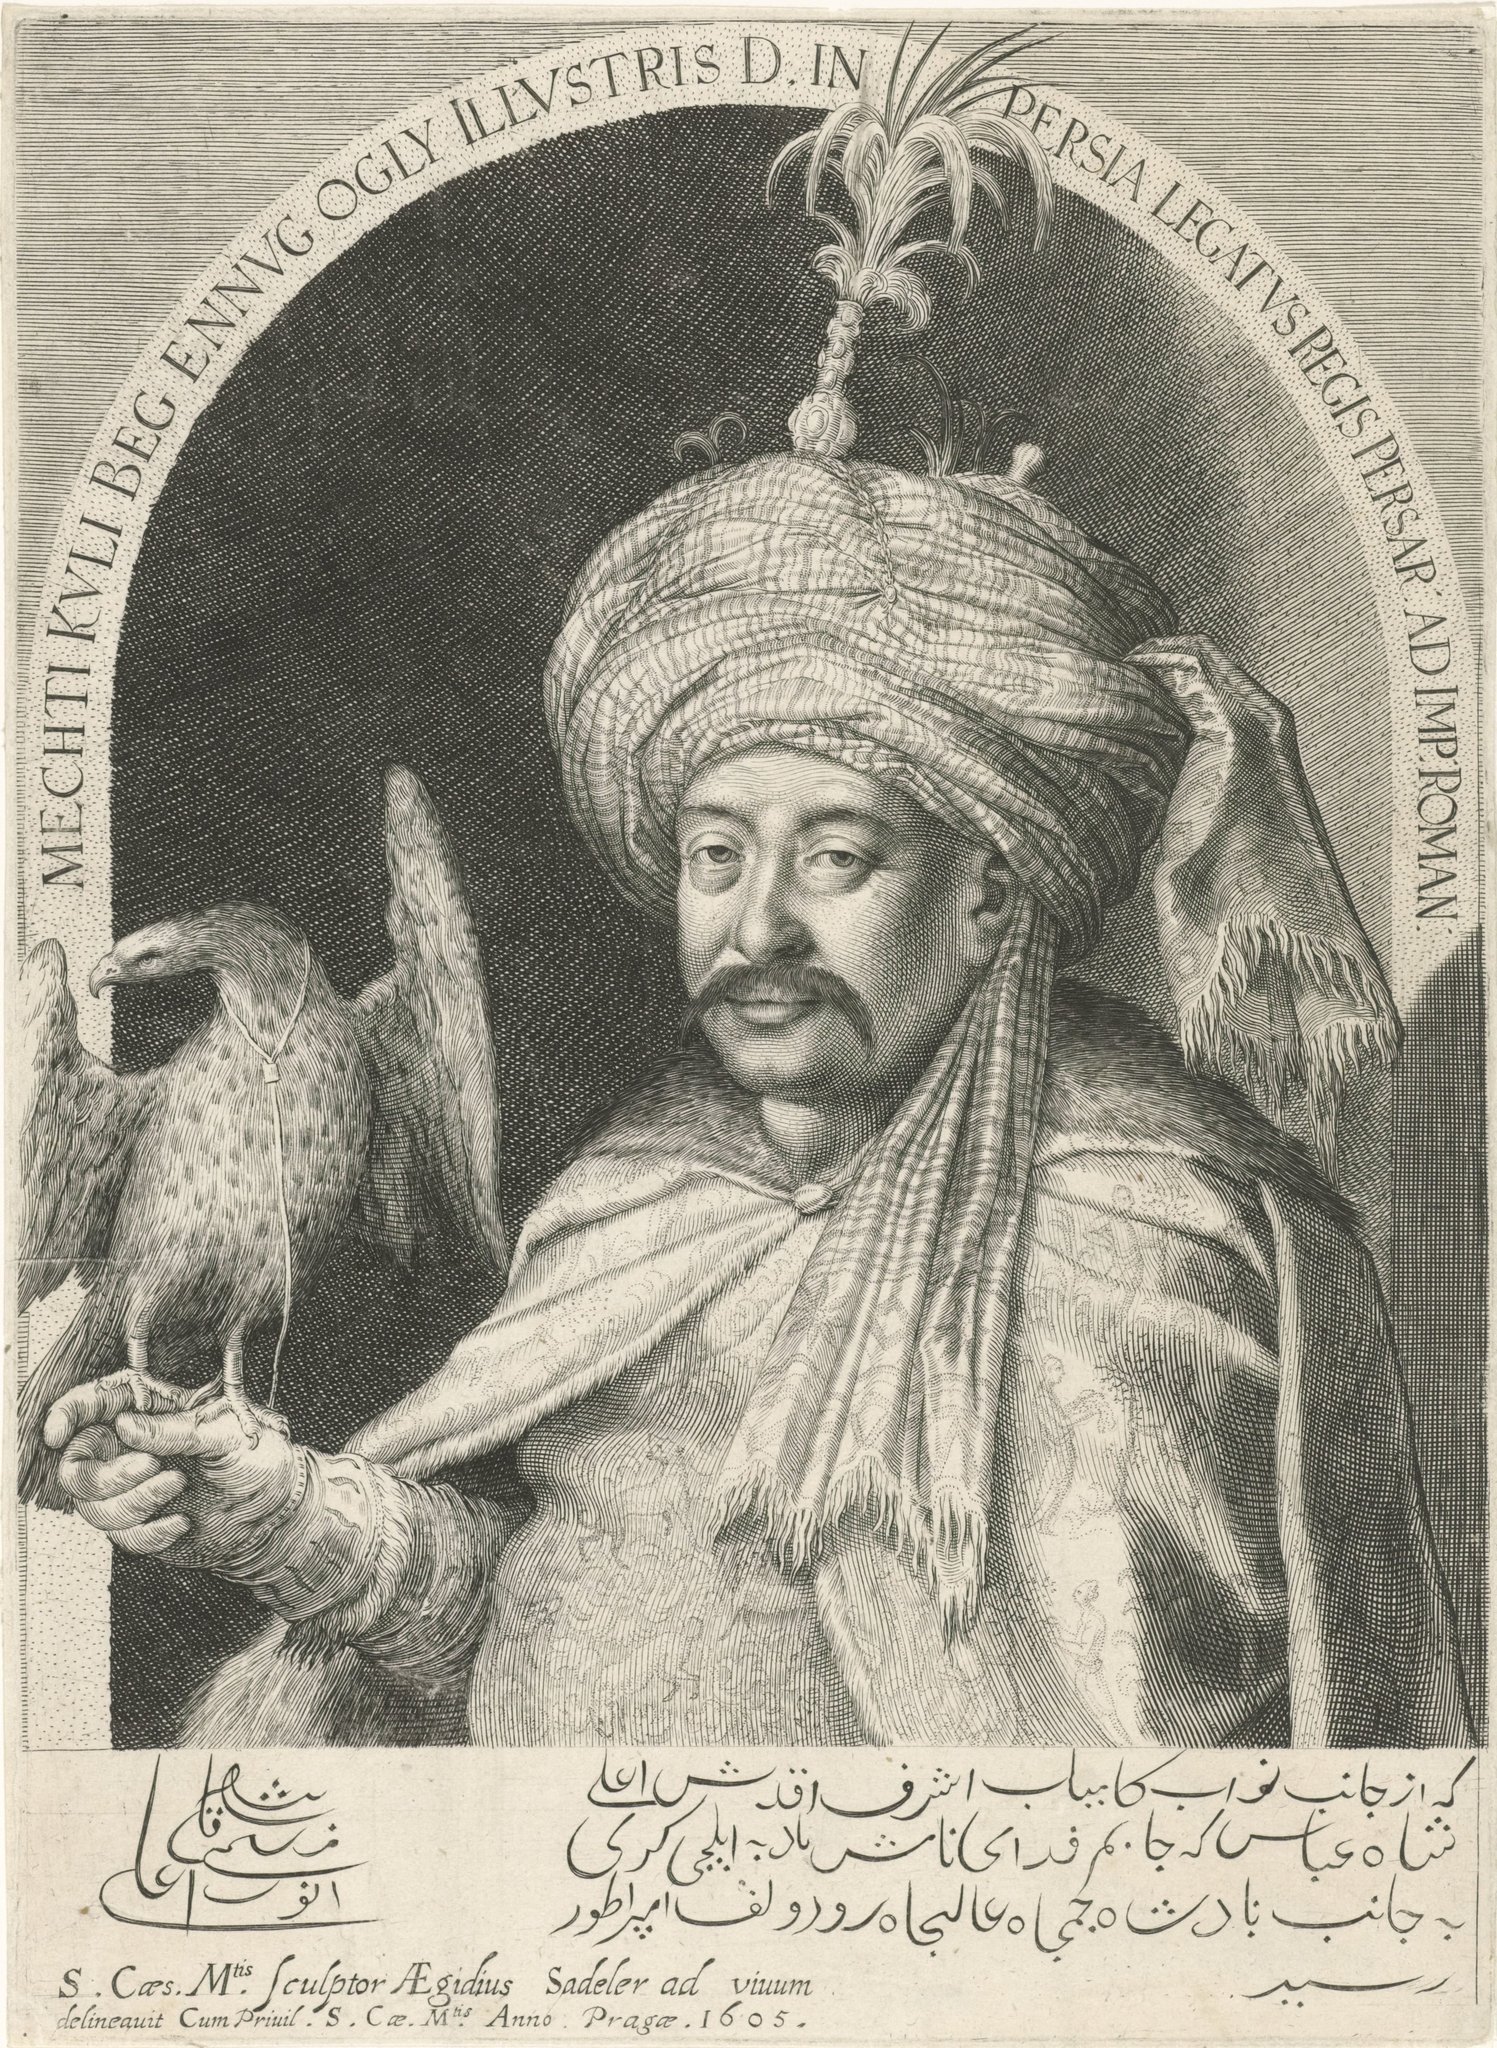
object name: print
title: Portret van Mechti Kuli Beg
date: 1605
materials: paper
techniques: engraving, etching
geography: prague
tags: predatory birds: eagle, head-gear: turban, asiatic races and peoples: persians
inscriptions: collector's mark: Lugt 240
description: Mechti Kuli Beg, ambassadeur van Perzië aan het keizerlijk hof van Rudolf II in Praag. Hij draagt een tulband. Op zijn rechterhand een adelaar. De prent heeft een Arabisch onderschrift.